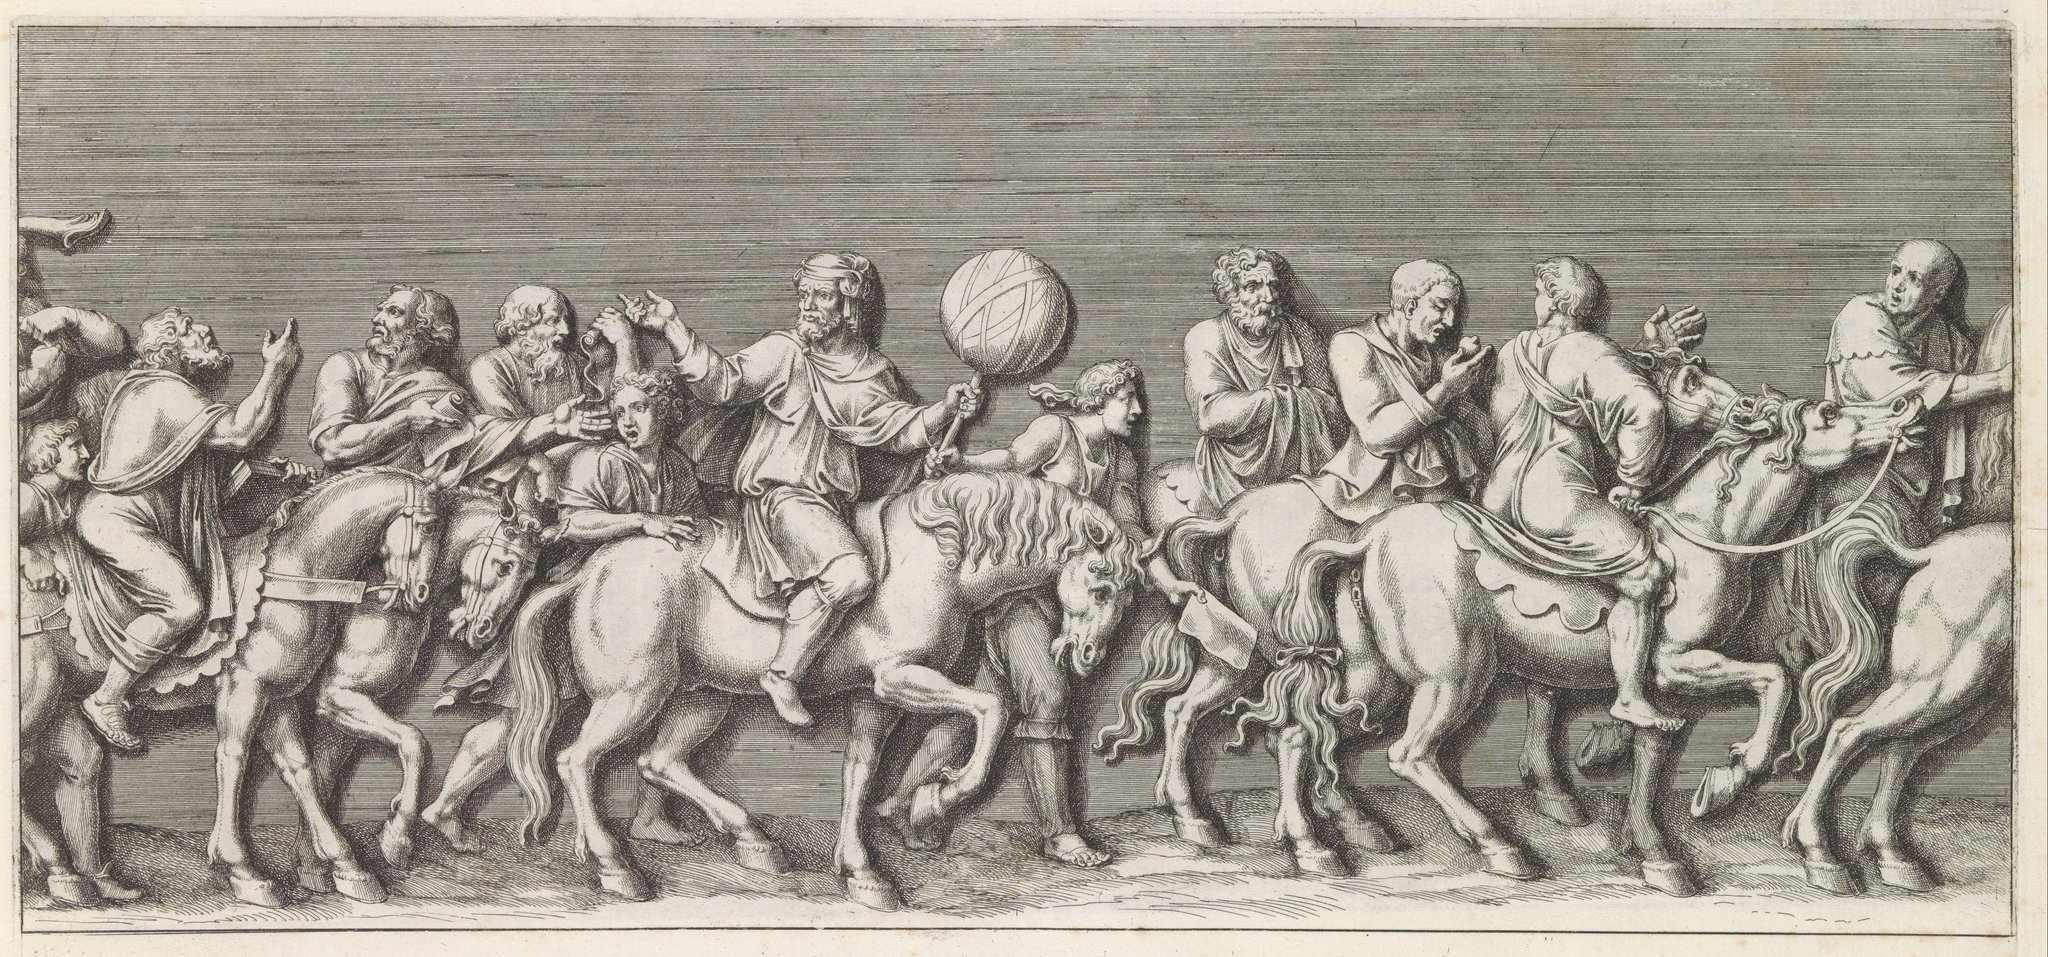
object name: album leaf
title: Sigismundi Augusti Mantuam adeuntis profectio ac triumphus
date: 1680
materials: paper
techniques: etching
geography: vatican city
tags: triumphal entry and public reception, pageant, 'entrée solennelle', 'joyeuse entrée', politician, e.g. party leader, military parade, pageant, horse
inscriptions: number: ‘18’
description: Prent maakt deel uit van een reeks van 25 prenten (+ titelprent) naar het stucwerk door Giulio Romano en Francesco Primaticcio in de Sala degli Stucchi in Palazzo del Te te Mantua.